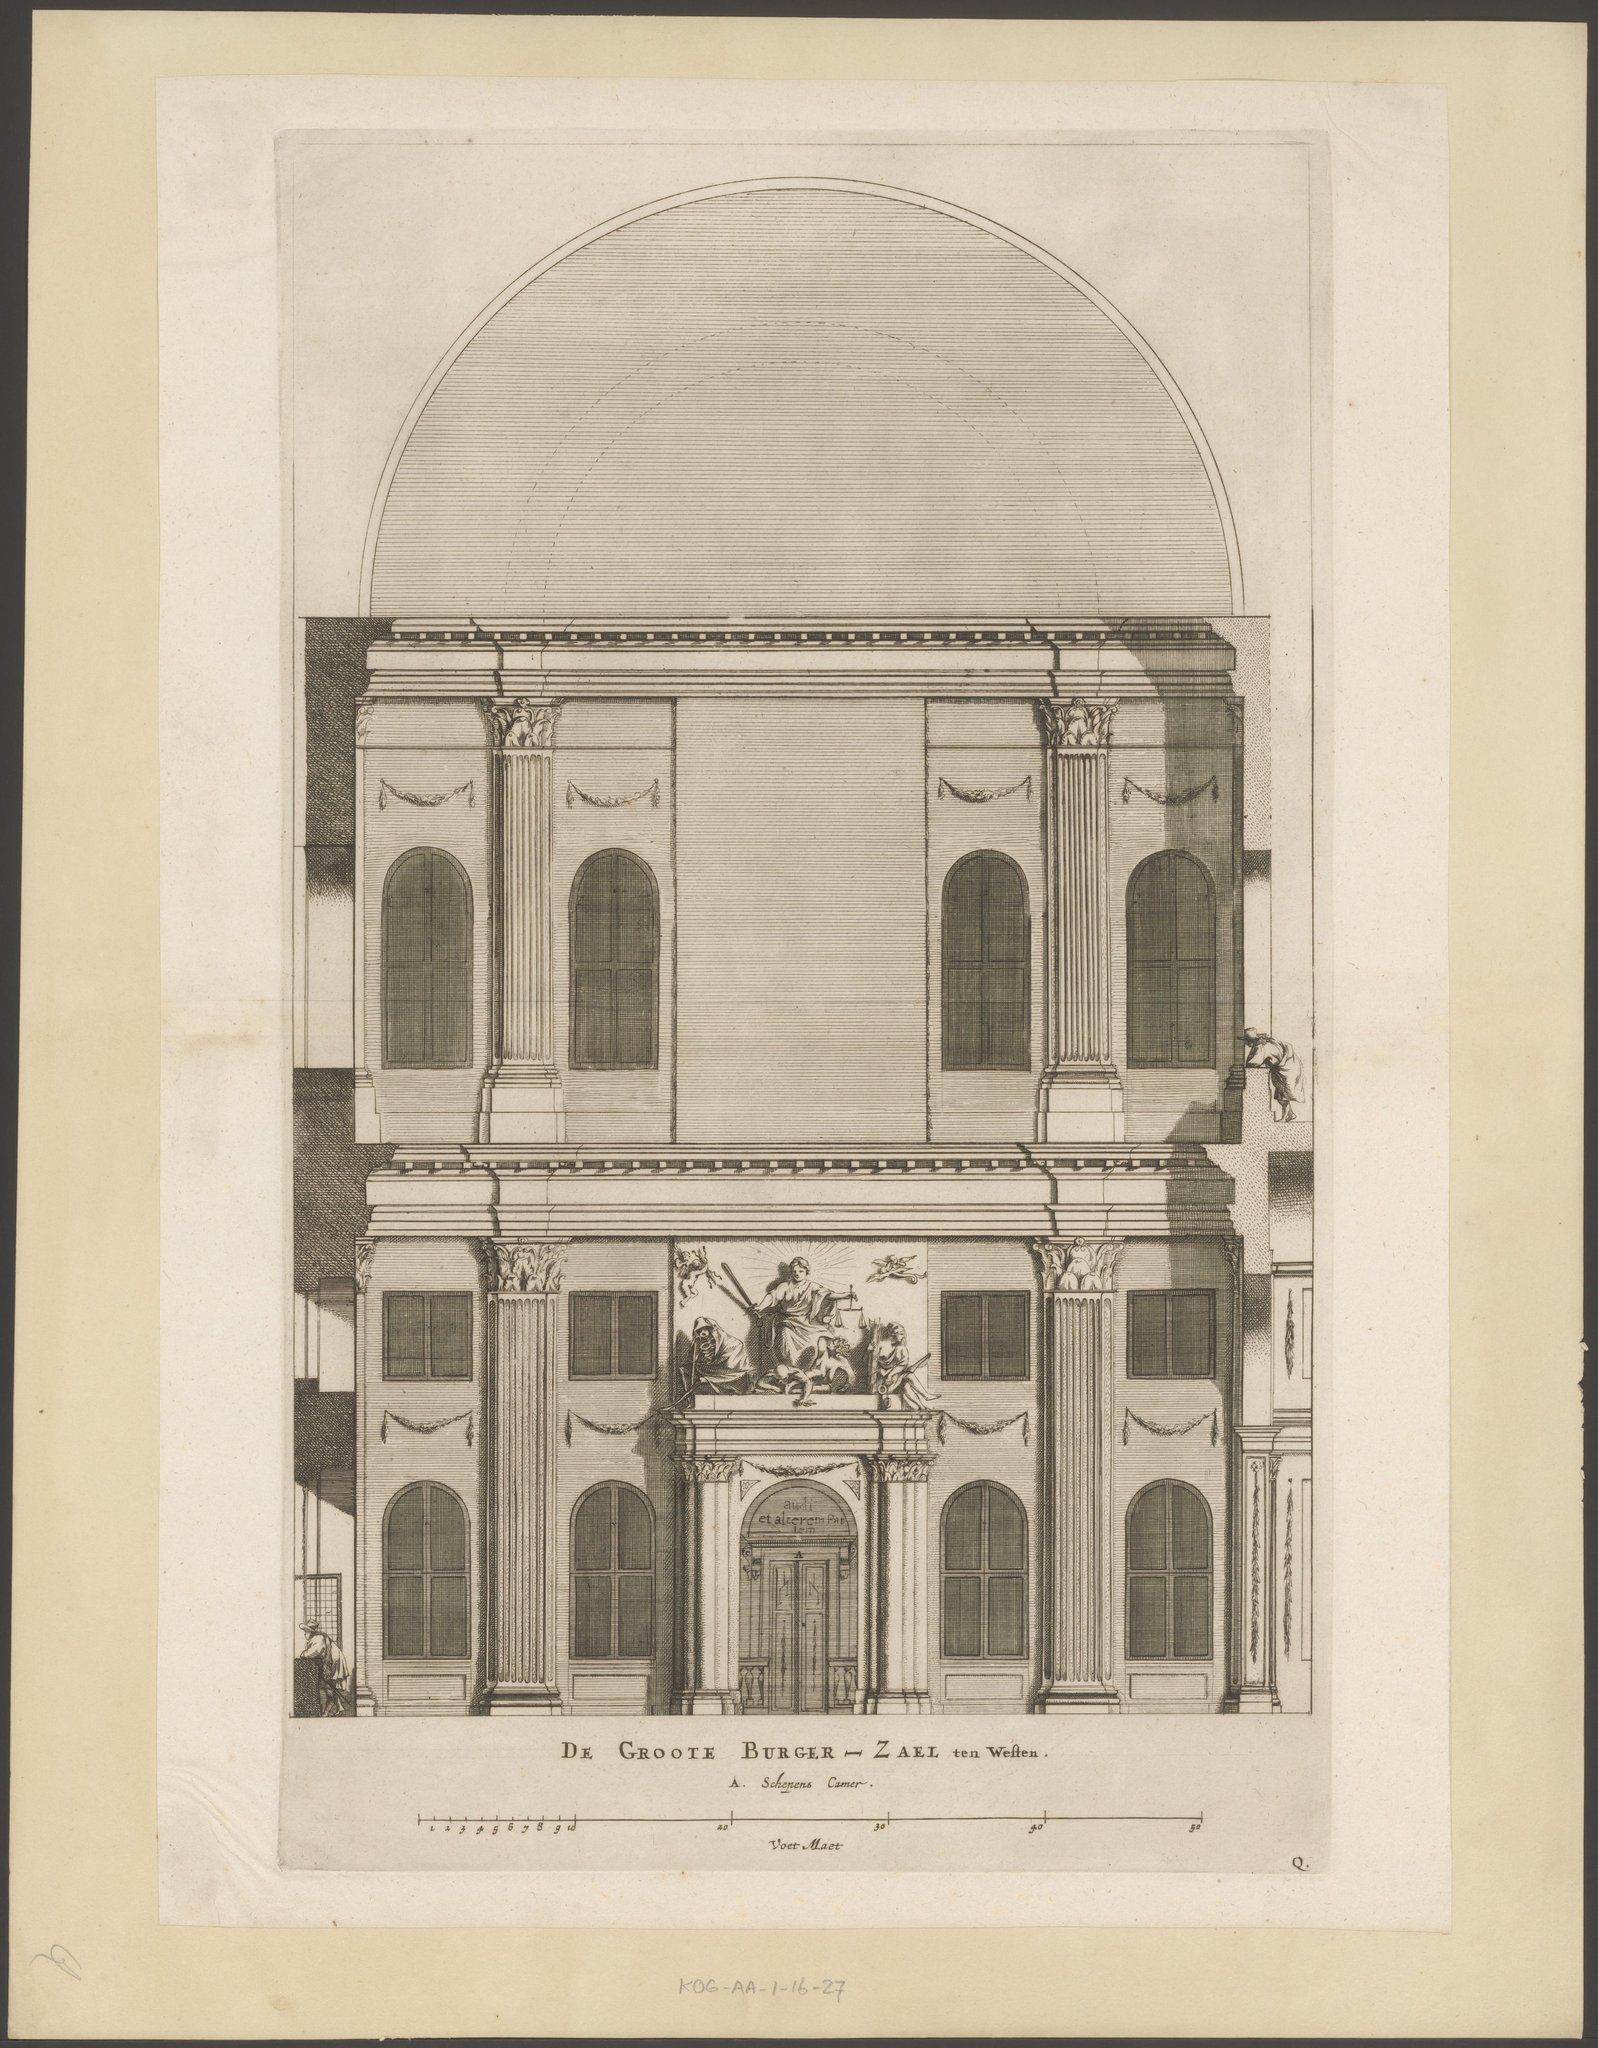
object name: print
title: De Groote Burger-Zael ten Westen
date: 1661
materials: paper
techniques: engraving, etching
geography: amsterdam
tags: envy; 'invidia' (ripa) ~ personification of one of the seven deadly sins, death as skeleton, interior ~ architectural design or model, justitia (justice) as roman personification, townhall, punishment; 'castigo', 'pena', 'punitione' (ripa), invidia (envy) as roman personification, (story of) midas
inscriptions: collector's mark: ‘16,27’ Lugt 1641b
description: Onderwerpsrubriek binnen de Atlas Amsterdam: Stadhuis op de Dam. Rechtsonder: Q.